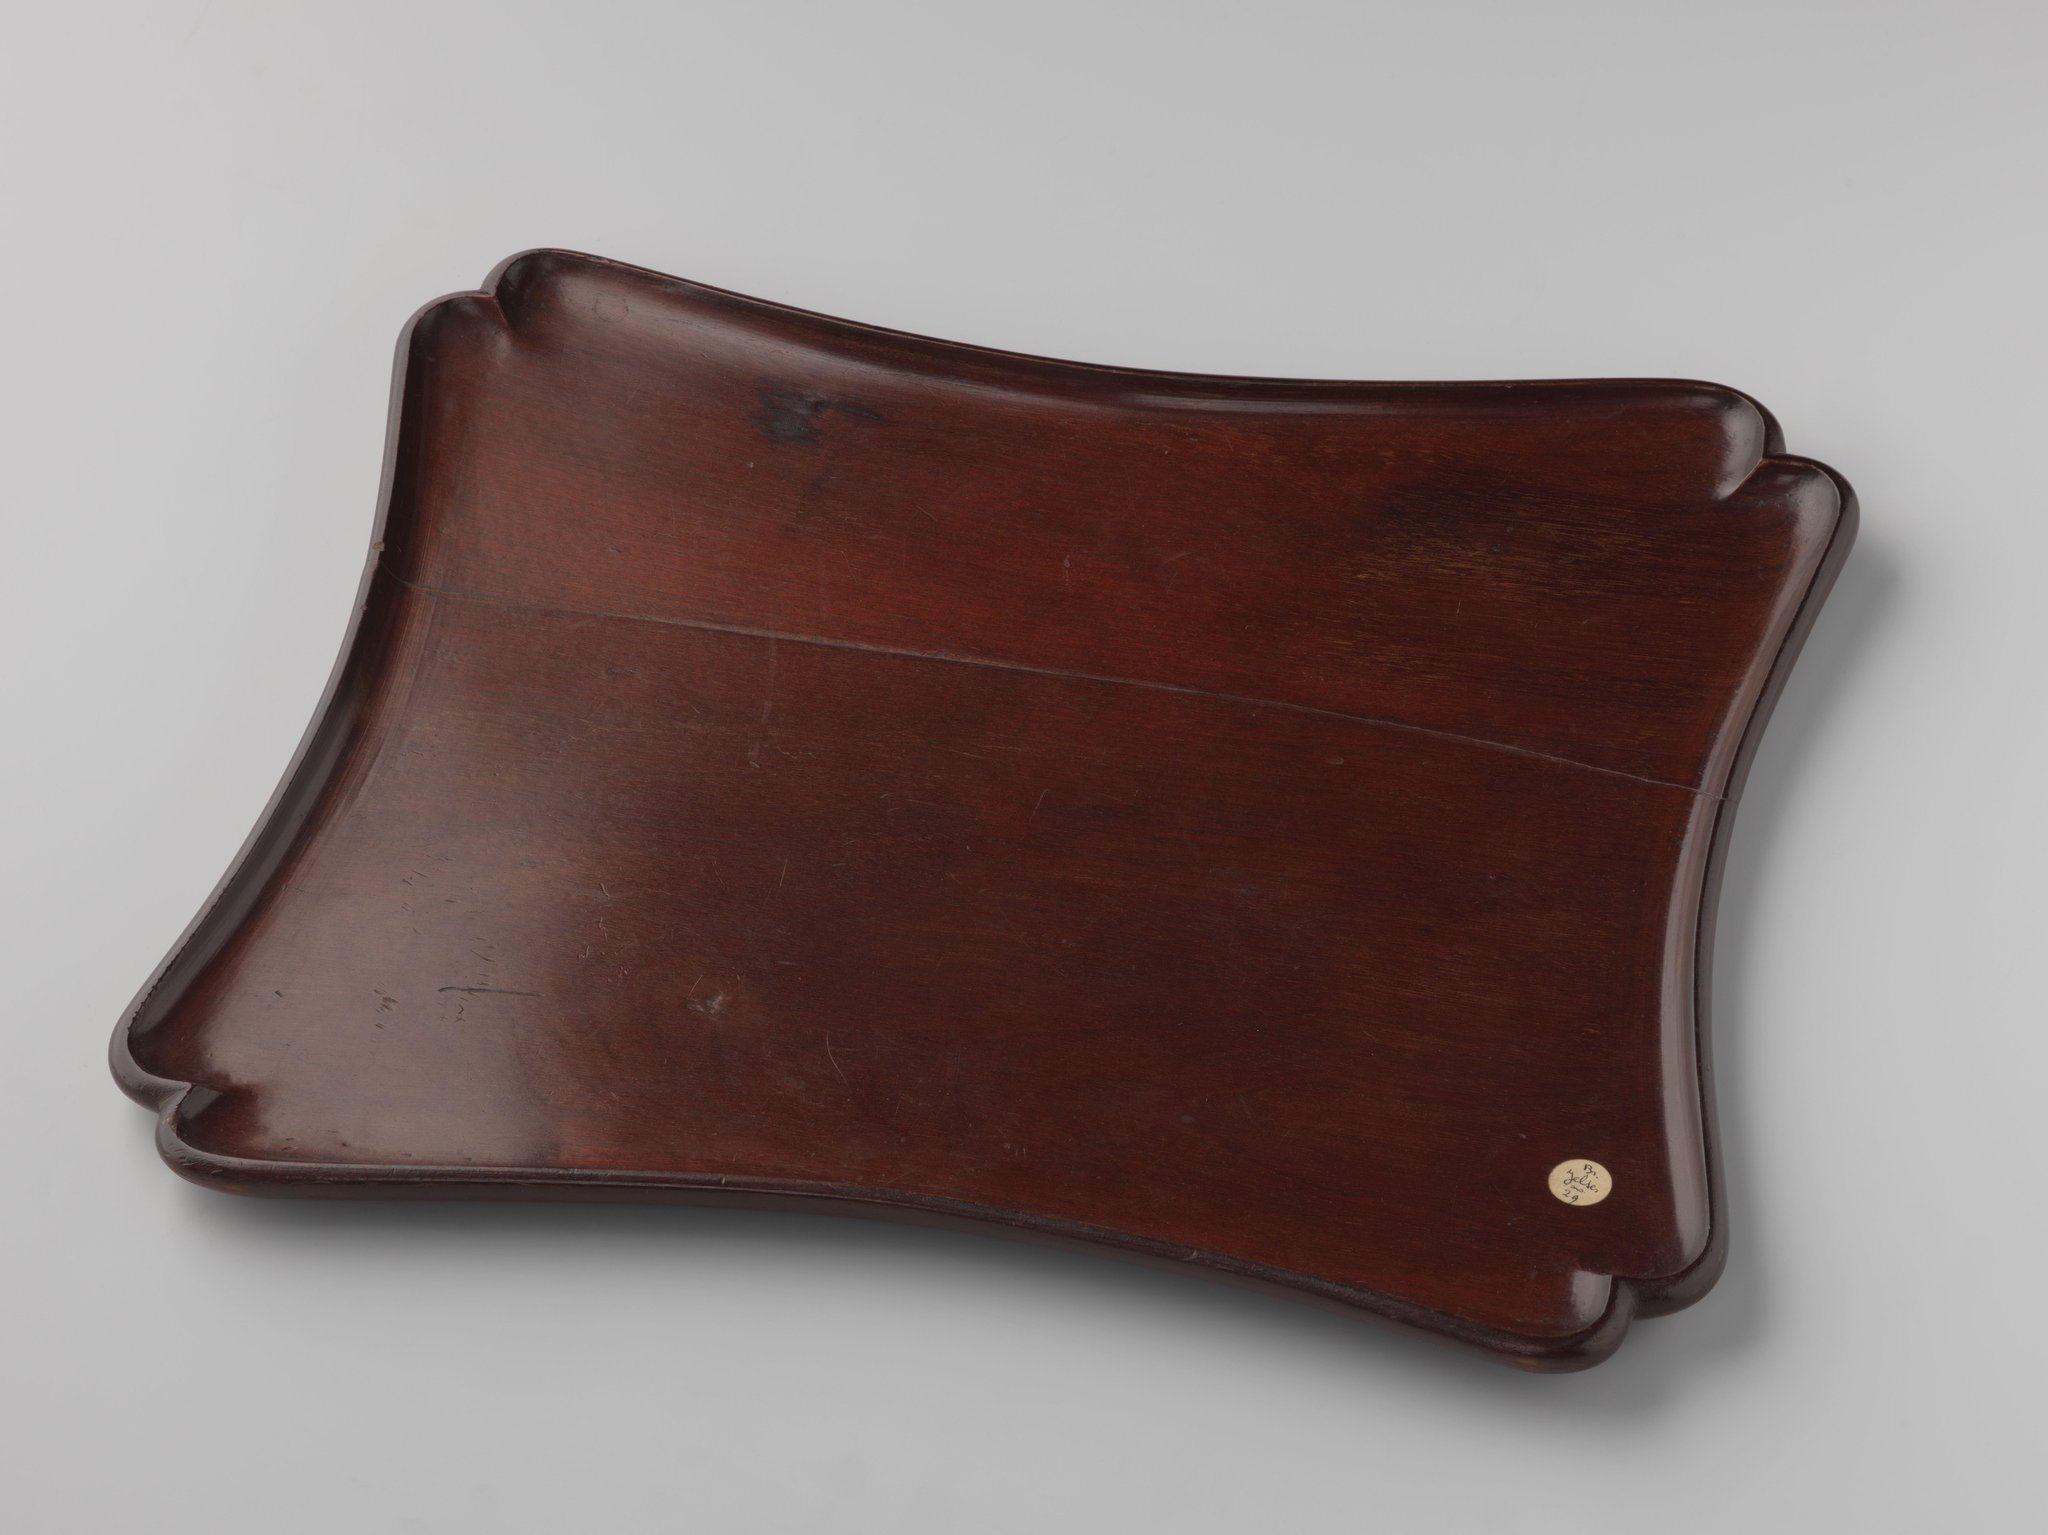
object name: blad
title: Presenteerblad van hout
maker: Anonymous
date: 1912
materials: wood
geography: netherlands